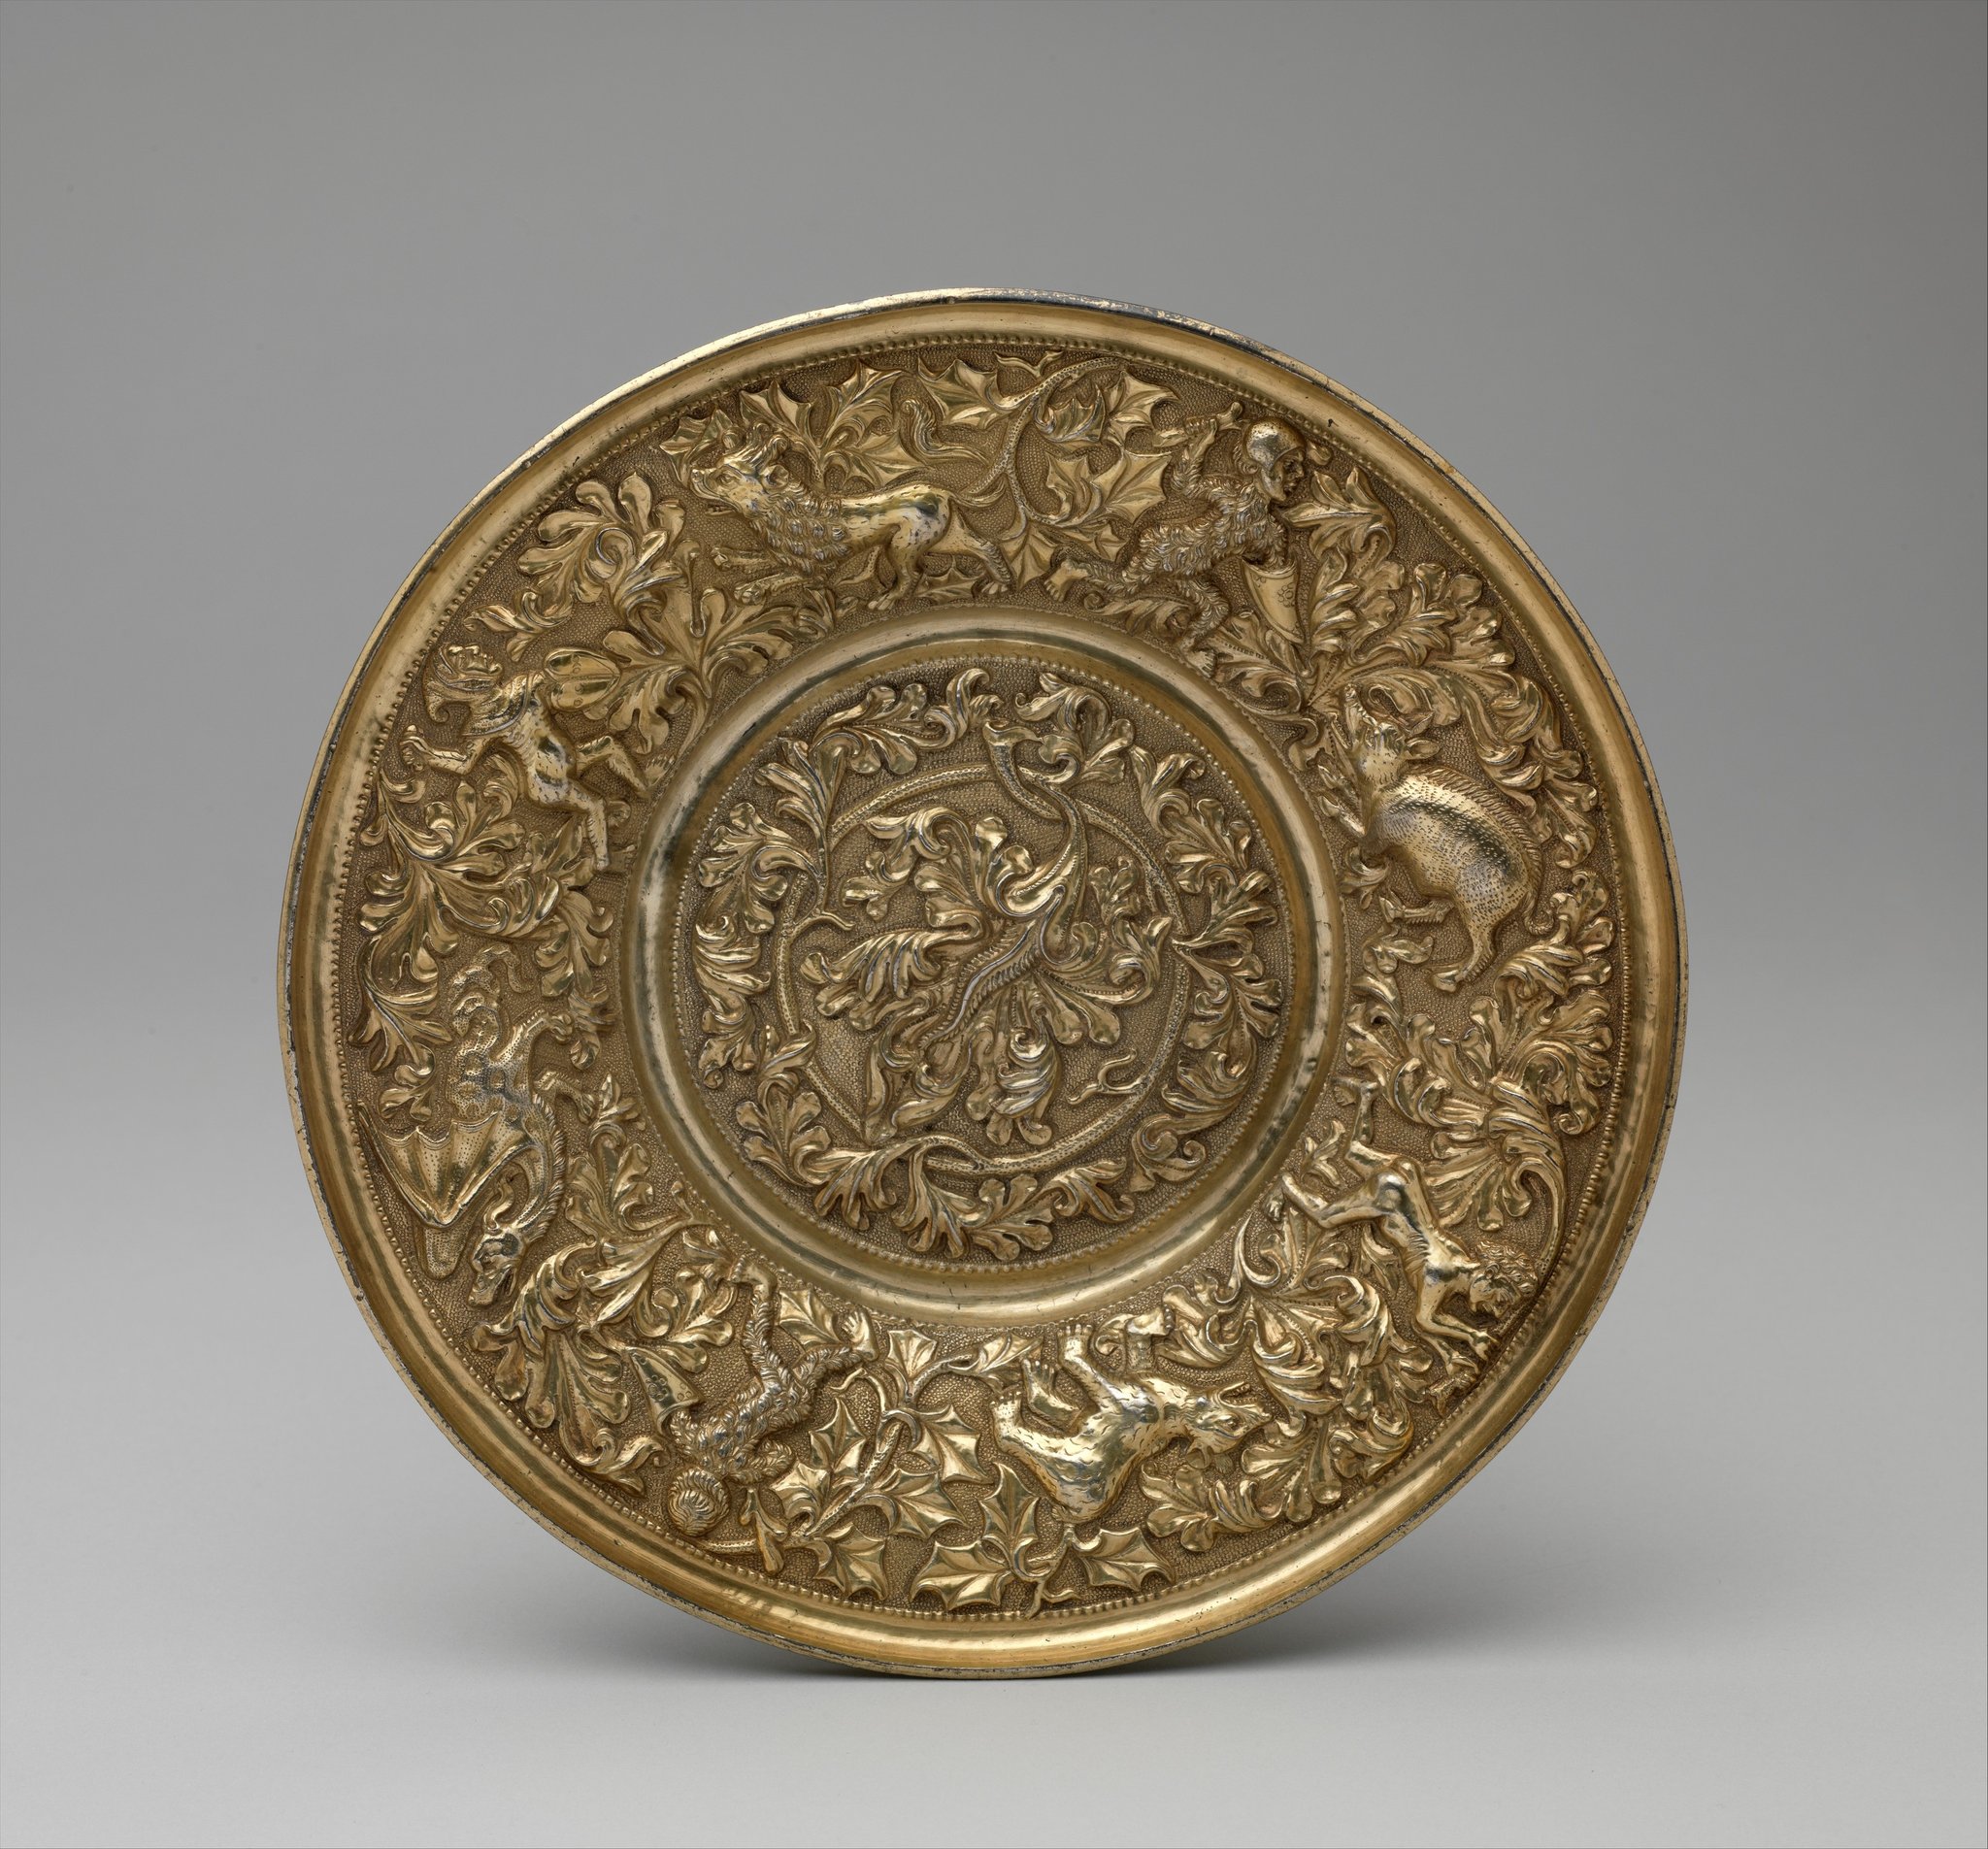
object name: plate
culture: italian or portuguese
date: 1500-1525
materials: silver gilt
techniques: embossing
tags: animals,leaves